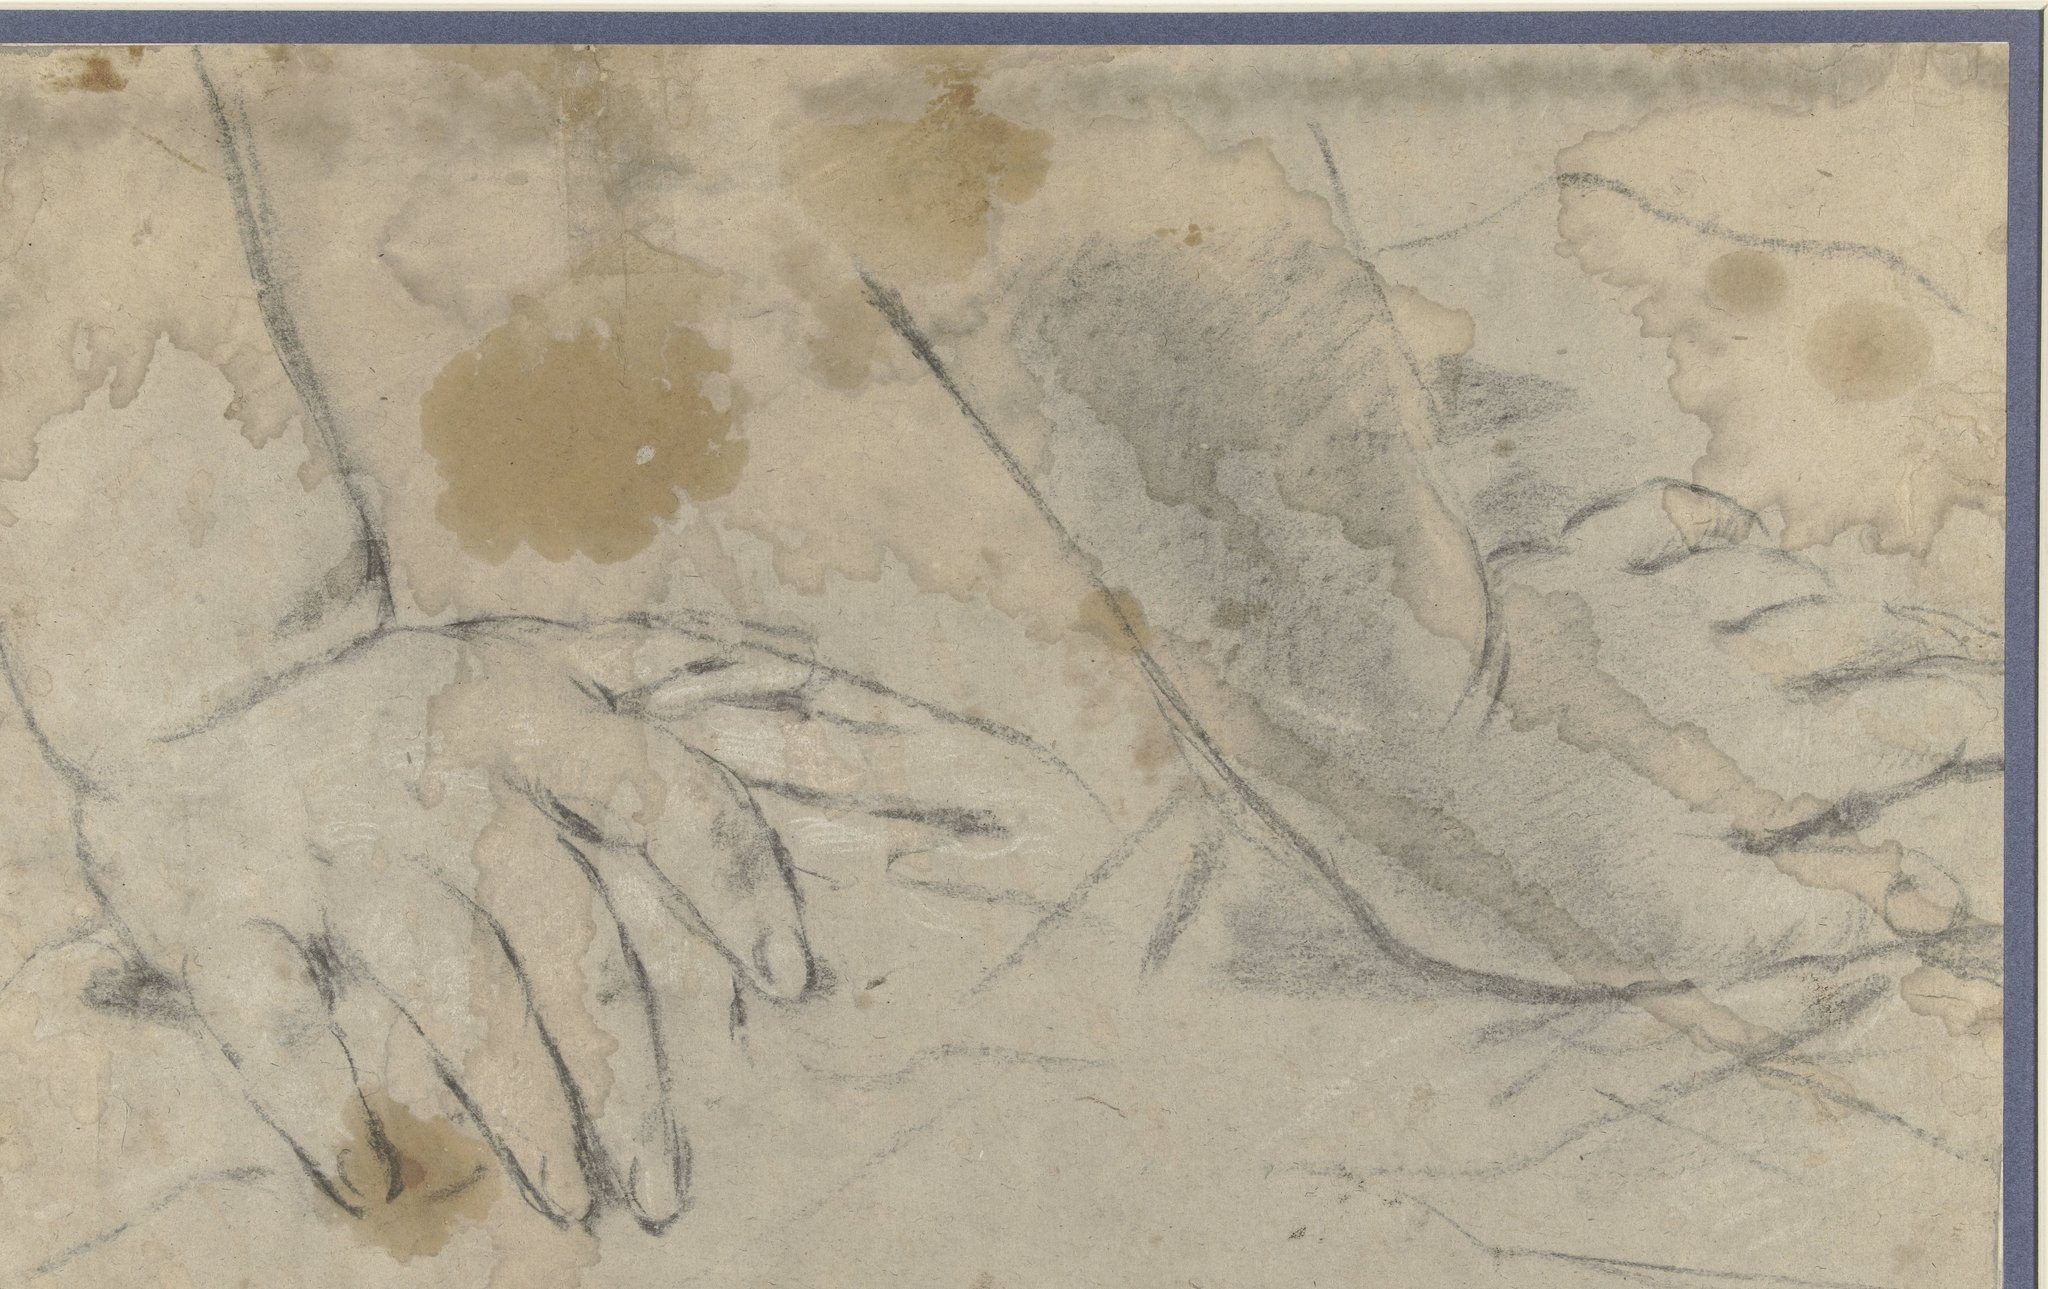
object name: drawing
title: Studie van twee handen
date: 1600-1628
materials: chalk, paper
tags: hand